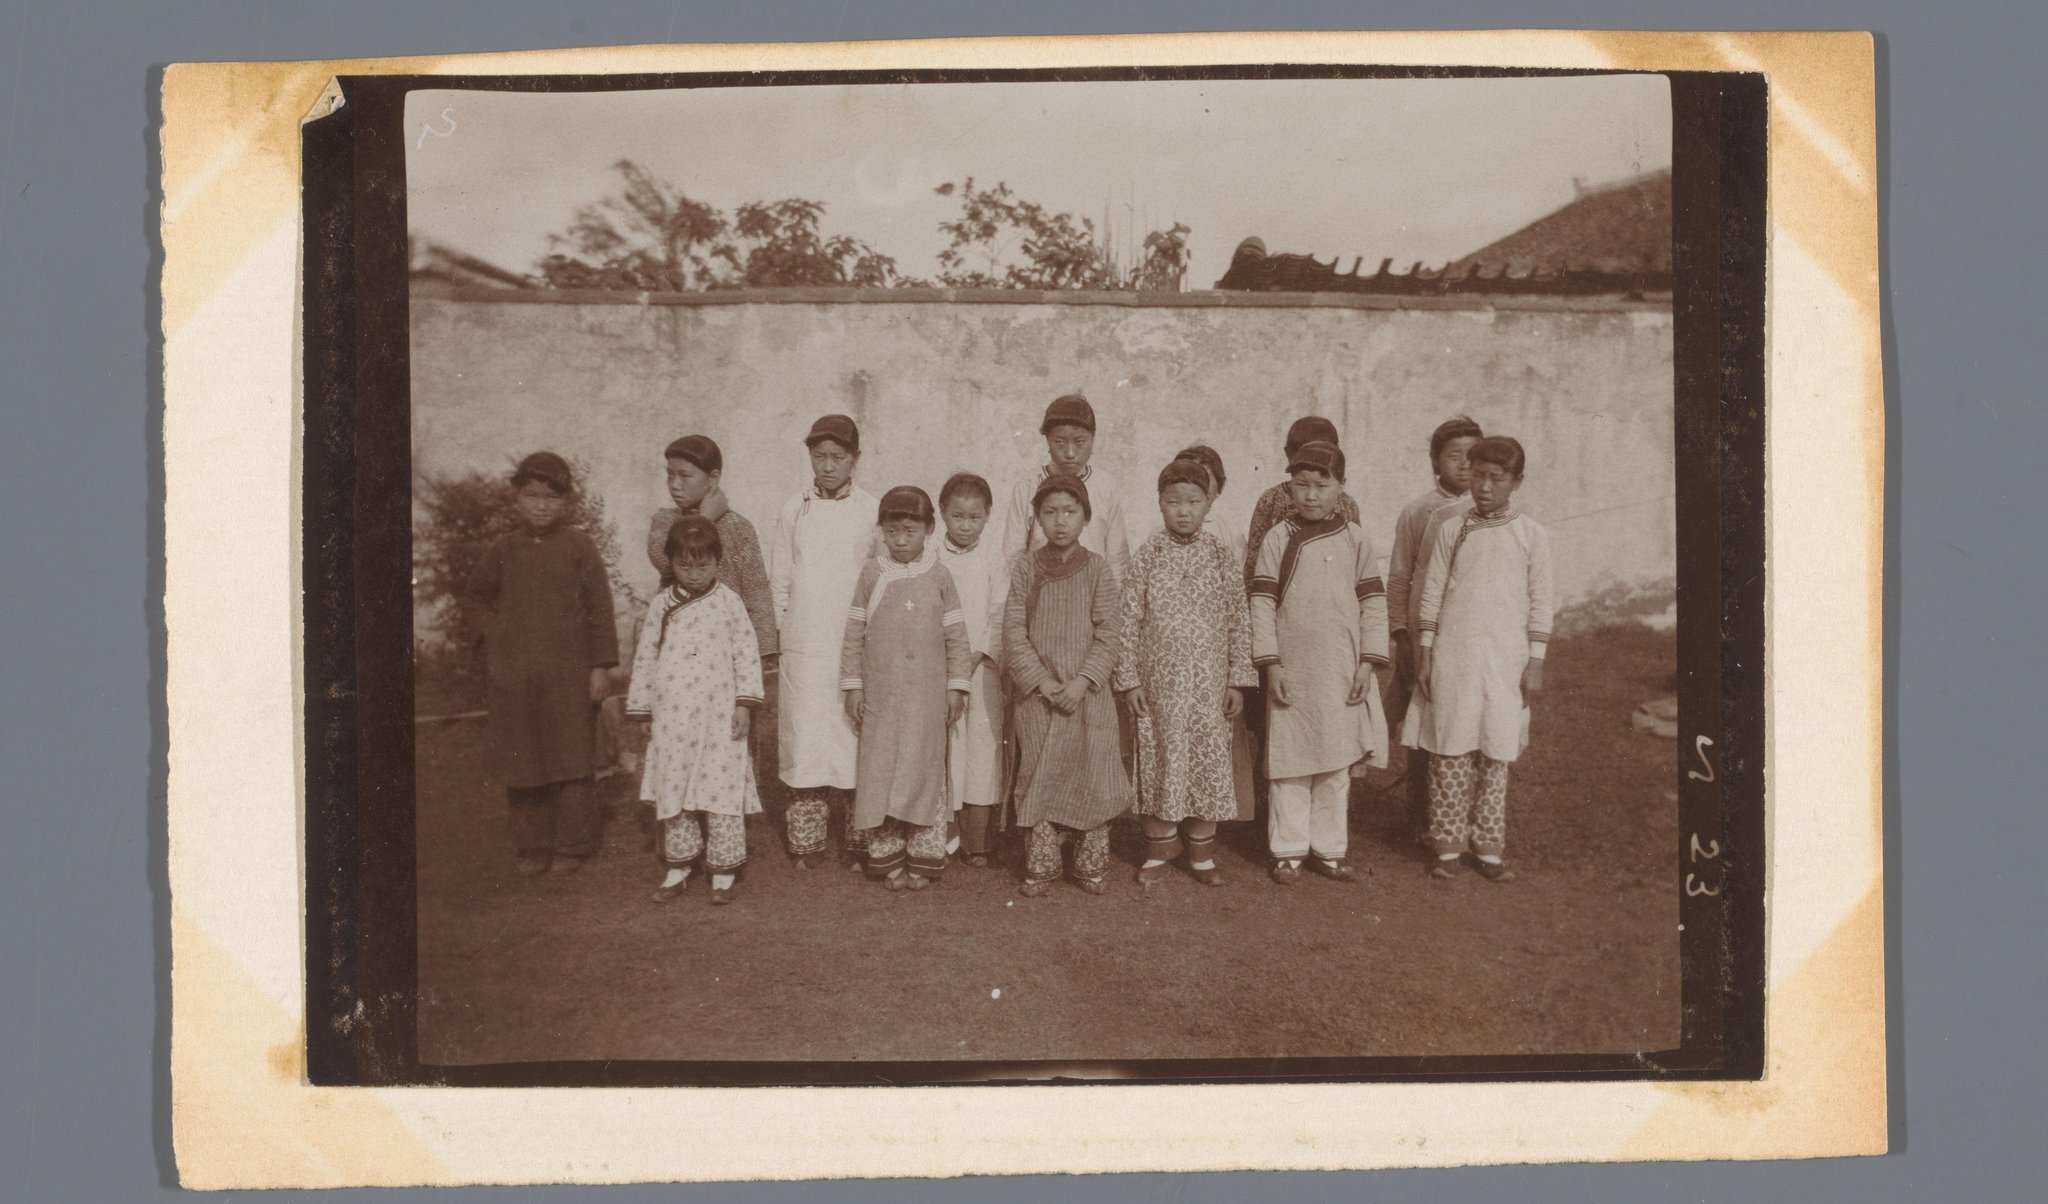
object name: photograph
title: Portret van een groep meisjes, China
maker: jan adriani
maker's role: fotograaf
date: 1907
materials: paper, photographic support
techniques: collodion silver print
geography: china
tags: girl (child between toddler and youth), anonymous historical persons portrayed in a group, in a group-portrait, china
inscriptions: address: ‘Weledelgeb. Hee[..] / Dr J.B. Adriani-[...] / Nieuwe Gr[...]/U[...]’